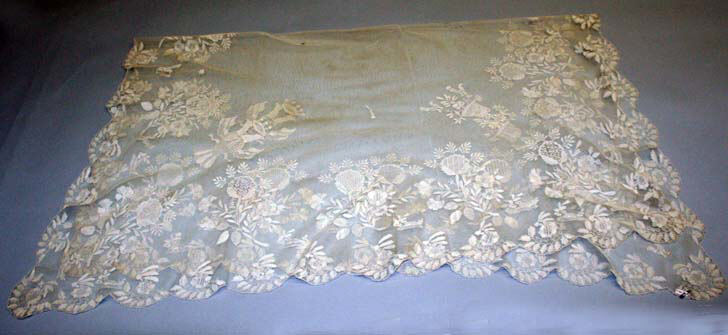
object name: wedding veil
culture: italian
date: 1825